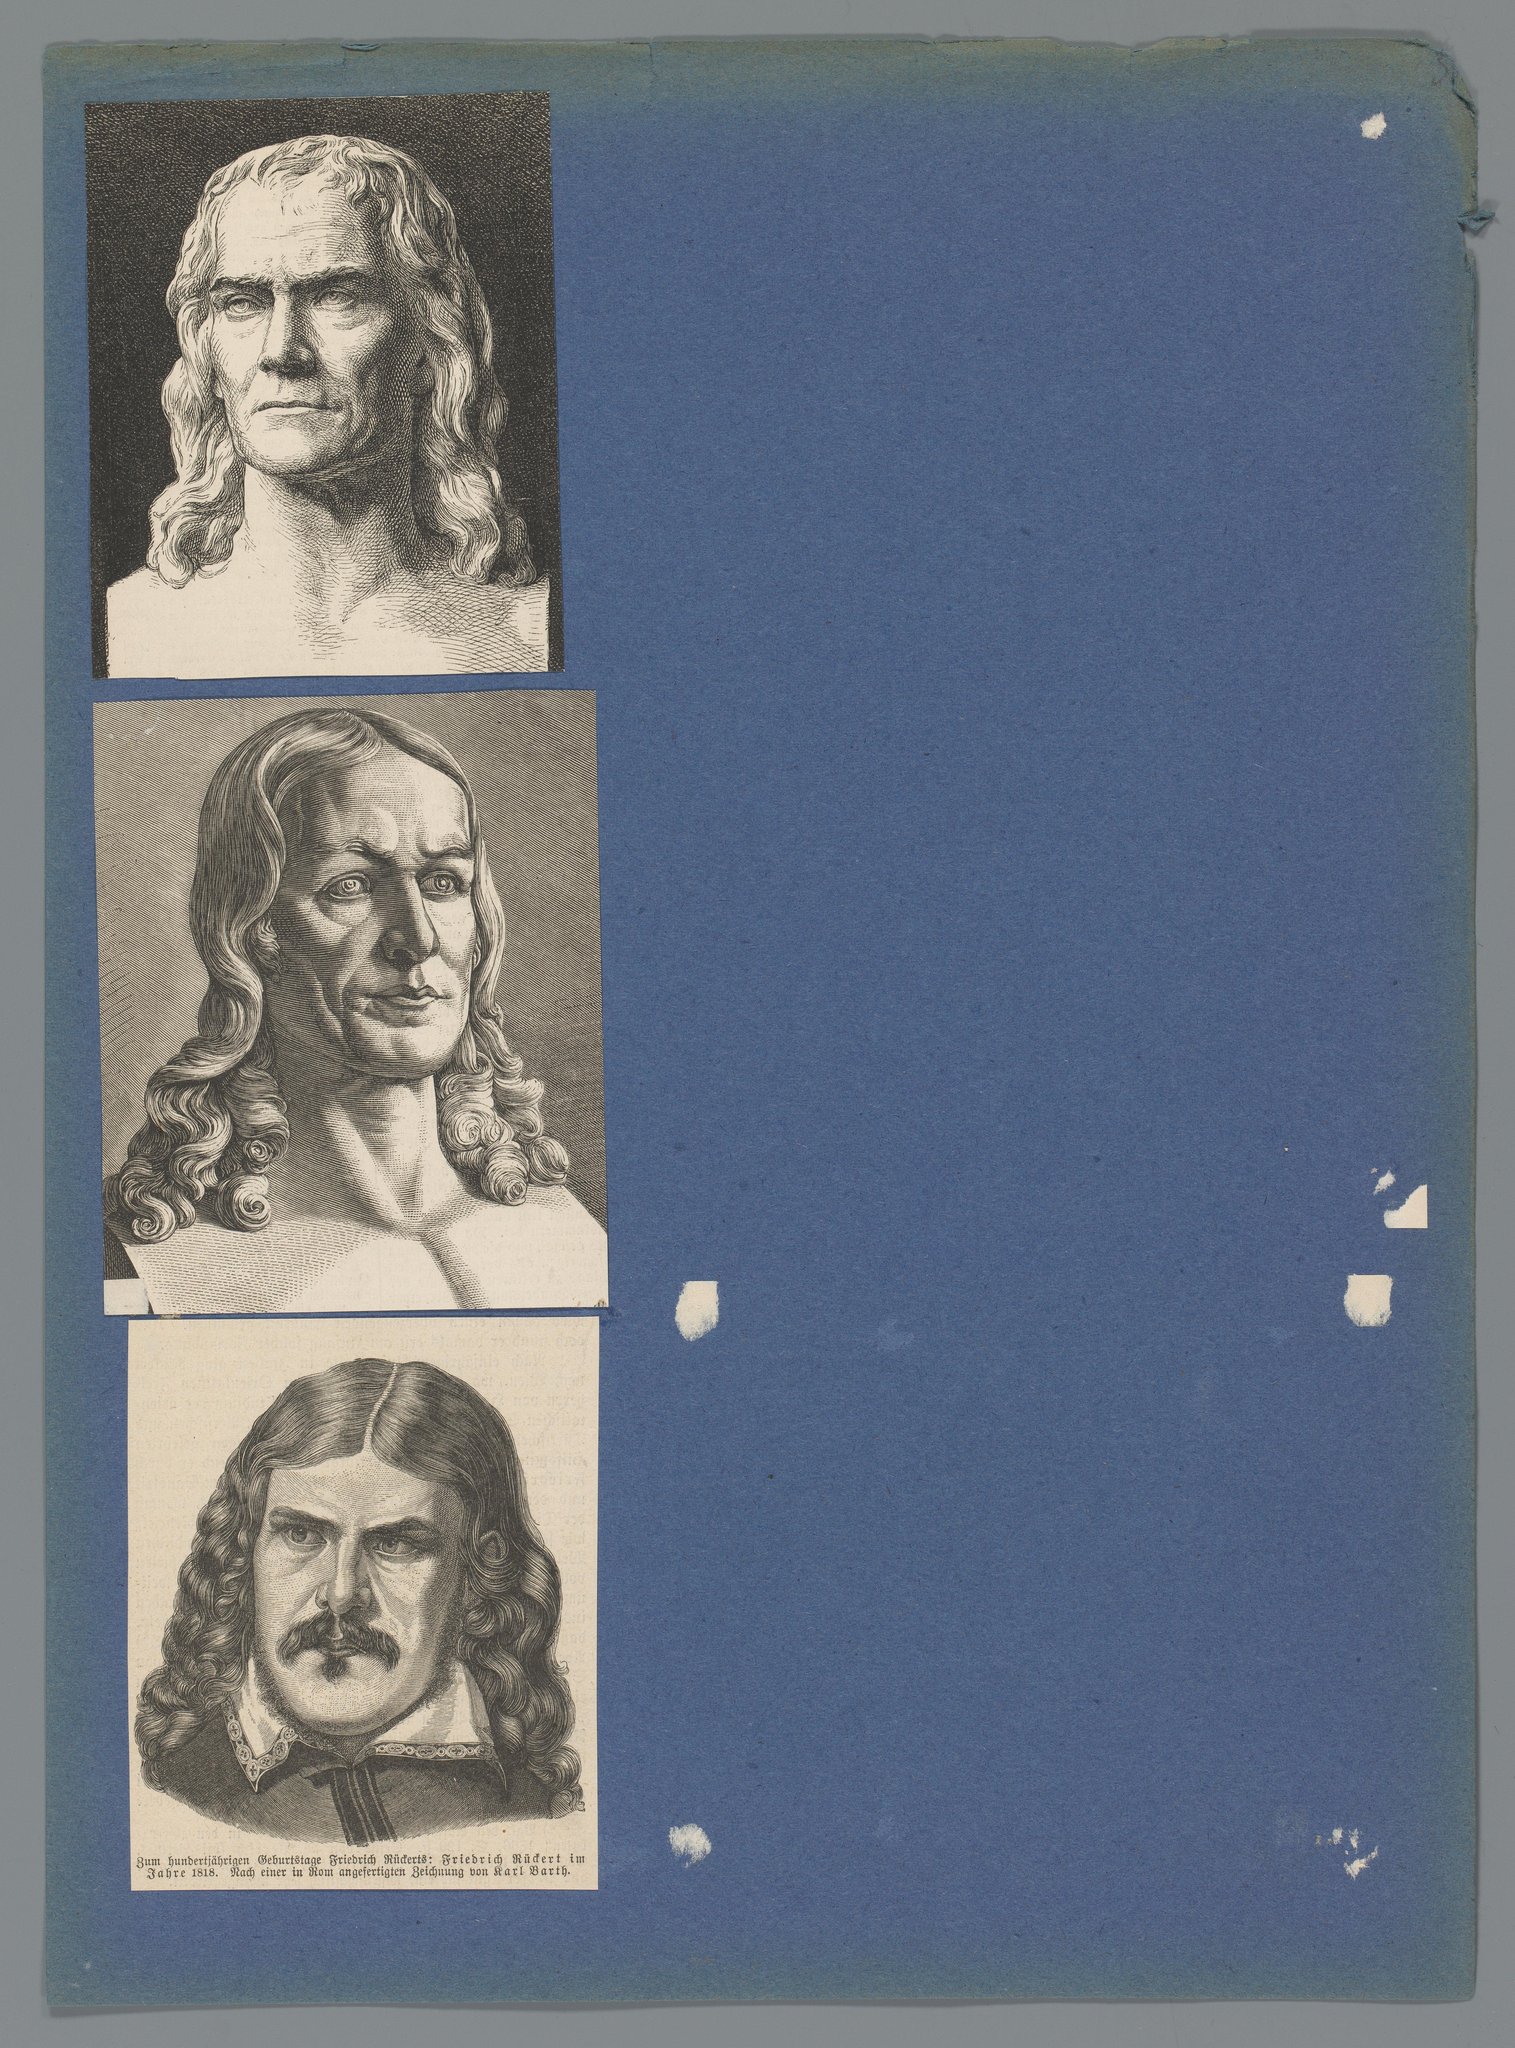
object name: print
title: Blad met drie portretten van Friedrich Rückert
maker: Anonymous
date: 1850-1900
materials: paper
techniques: letterpress printing, snipping, engraving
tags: friedrich rückert, historical persons, portrait of a writer